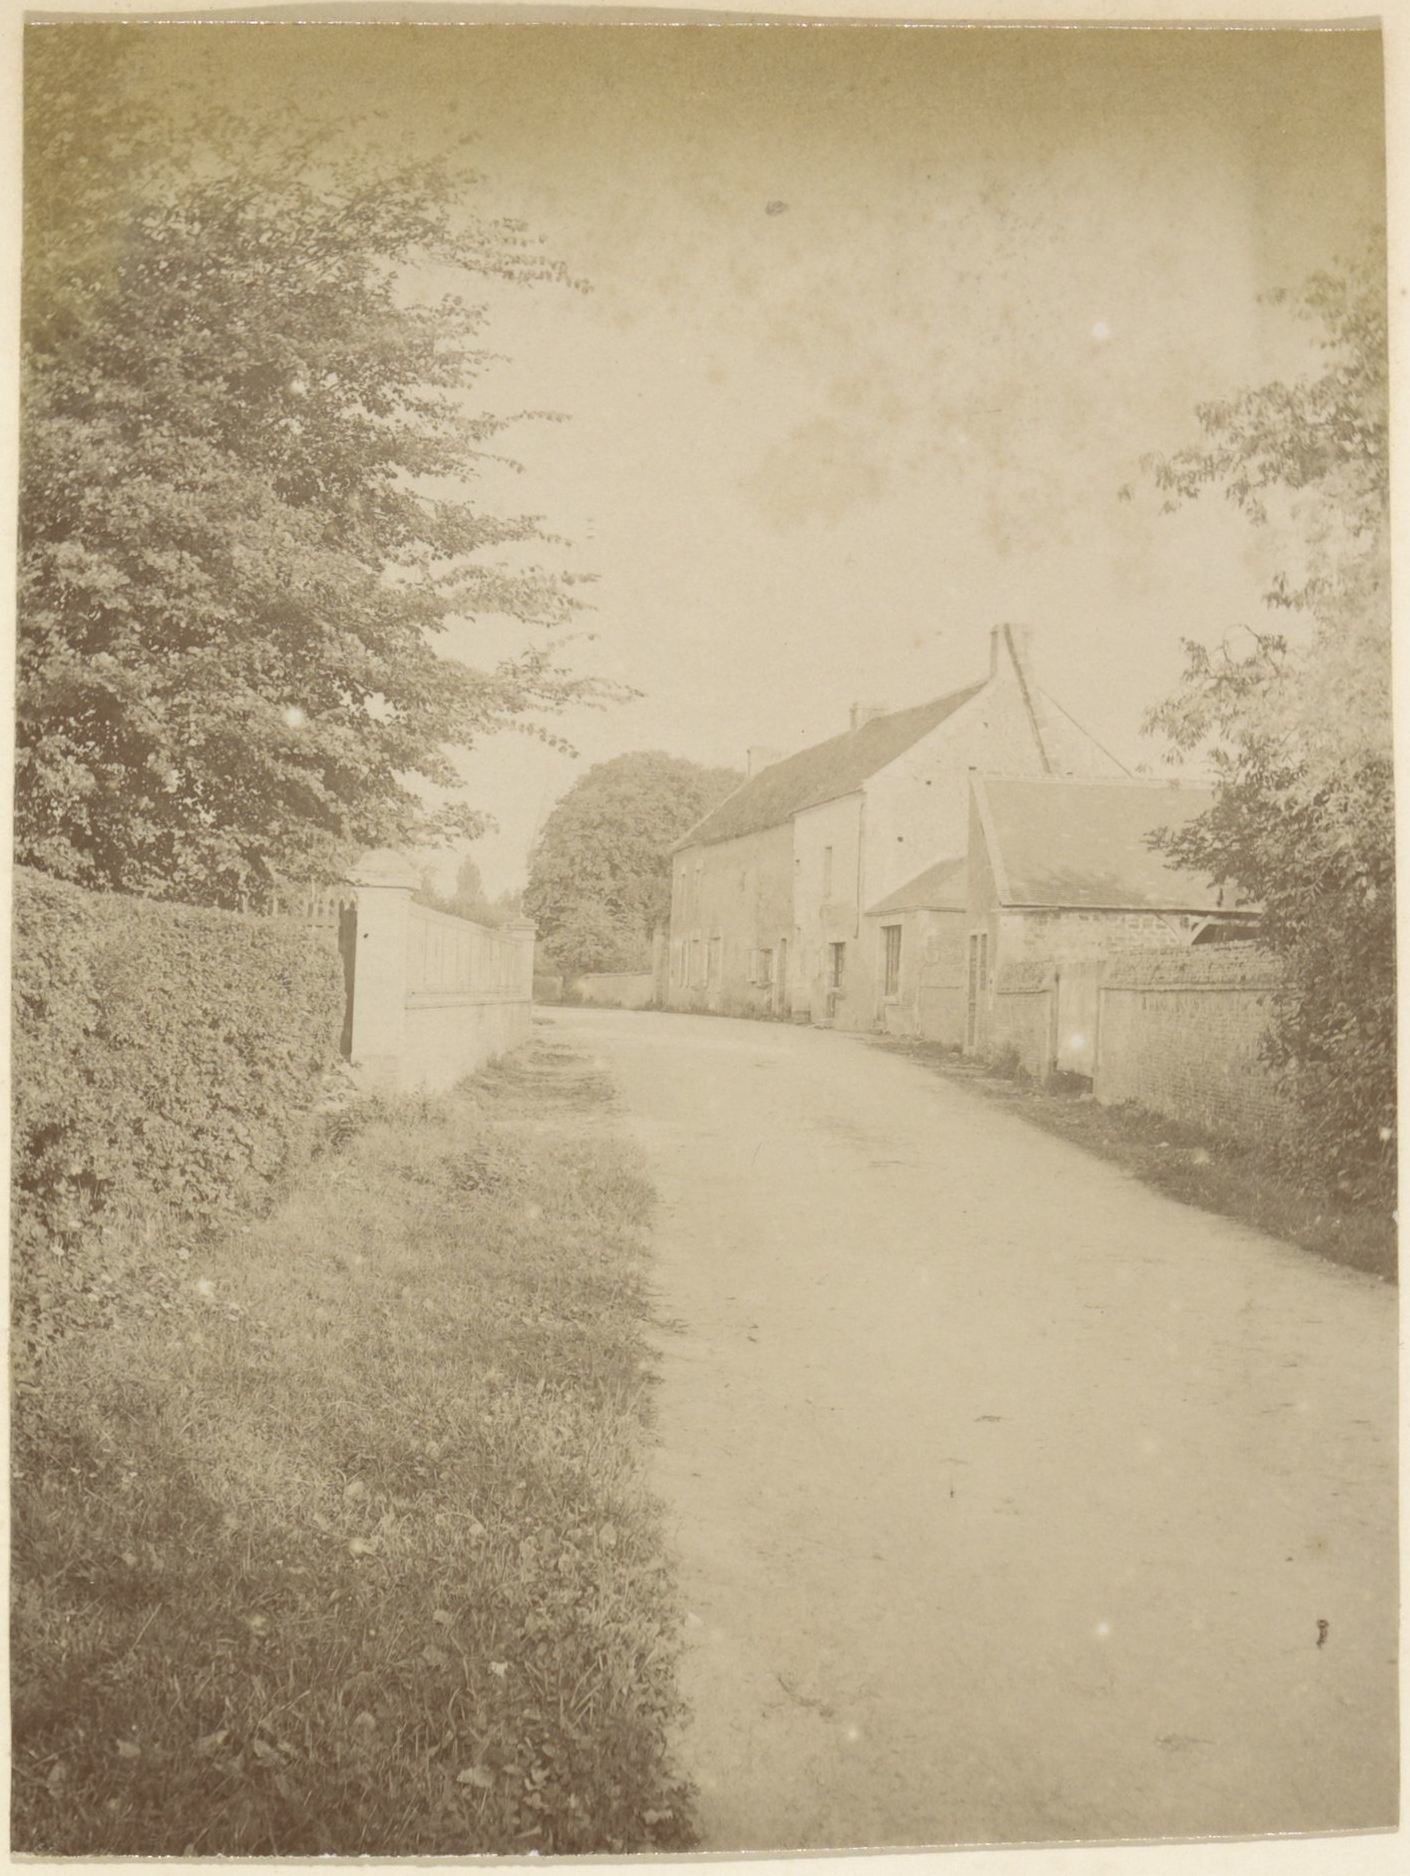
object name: photograph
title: Dorpsstraat in Frankrijk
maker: Anonymous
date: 1900-1910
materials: paper, photographic support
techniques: albumen print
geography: france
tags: public road in village, france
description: Onderdeel van Fotoalbum van een Franse amateurfotograaf met opnames van een familie, distilleerderij Delizy & Doistau Fils, het leger en bezienswaardigheden in Frankrijk.